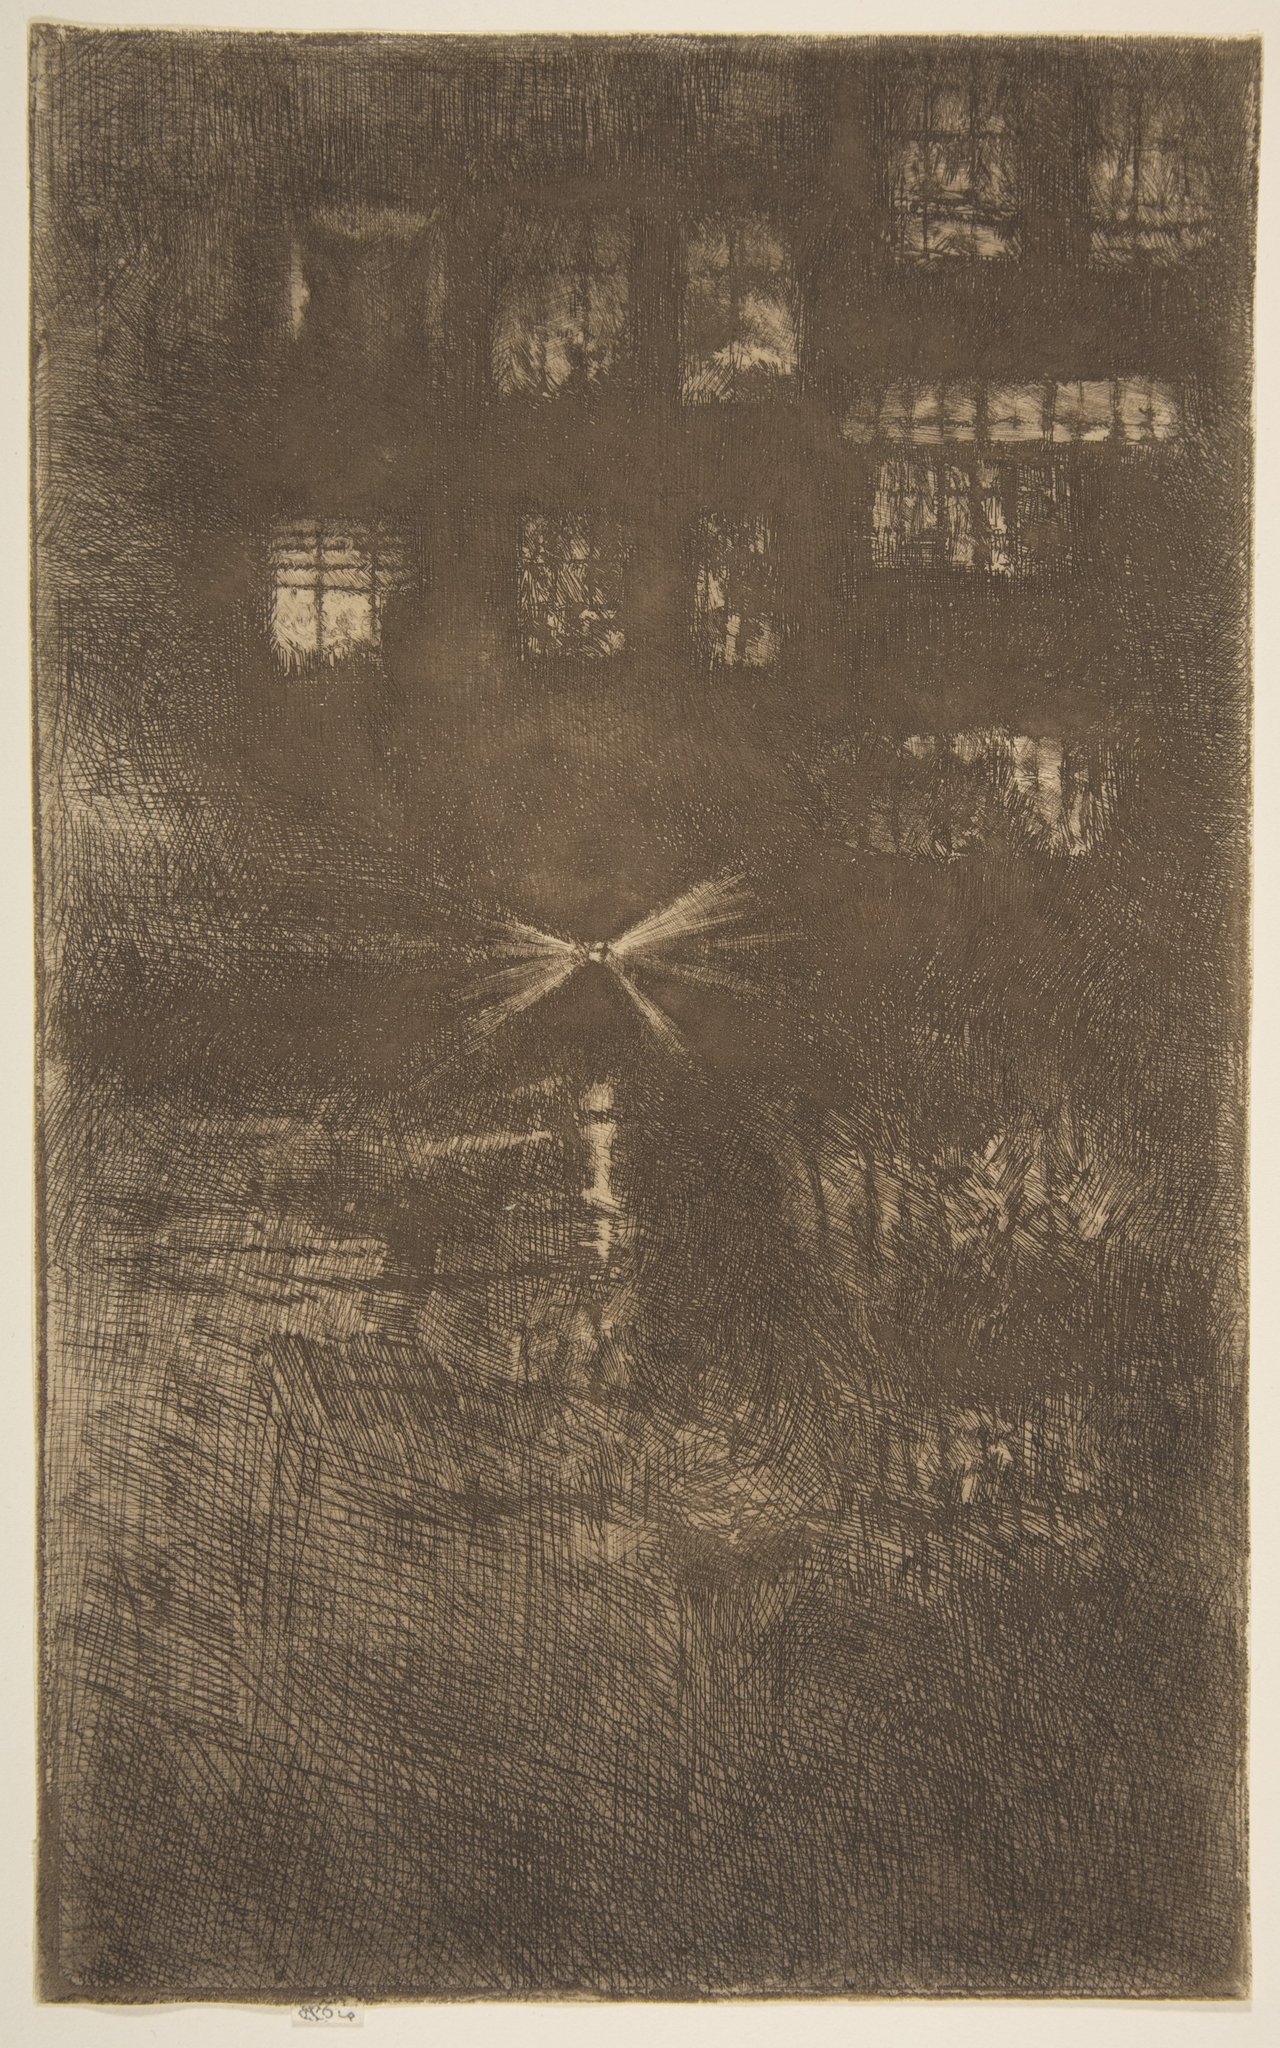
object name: print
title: Nocturne: Dance House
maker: james mcneill whistler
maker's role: artist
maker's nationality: american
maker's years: 1834-1903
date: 1889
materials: ink, paper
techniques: drypoint, etching, printing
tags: buildings,windows